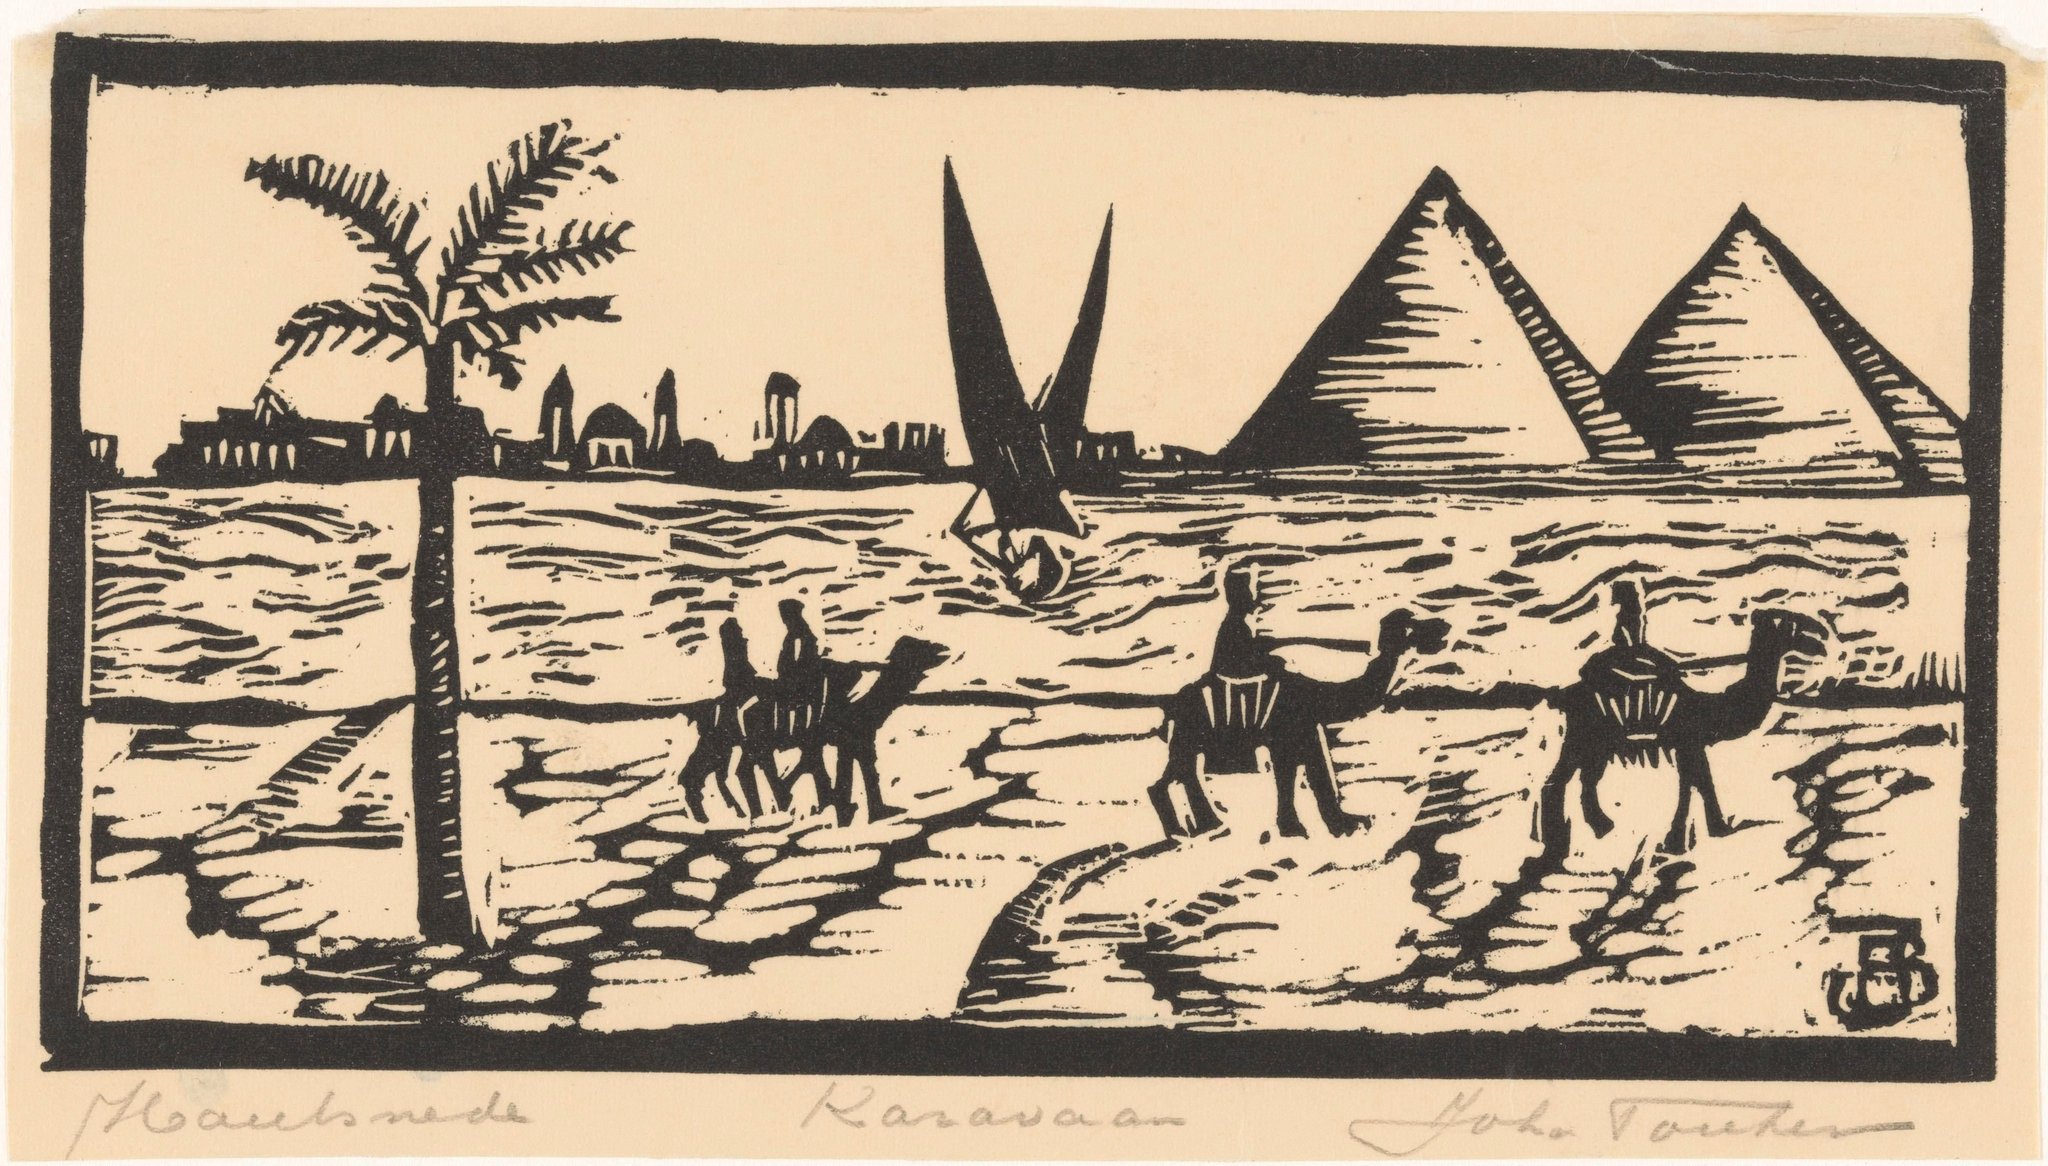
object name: print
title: Karavaan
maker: joh. fonken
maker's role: print maker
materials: paper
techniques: woodcut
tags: hoofed animals: camel, river, egyptian pyramids (wonder of the world)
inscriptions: collector's mark: Lugt 2760, collector's mark: Lugt 2228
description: Een palmboom en een karavaan met drie kamelen langs een rivier waar een zeilboot op vaart. Rechts op de achtergrond twee piramiden.